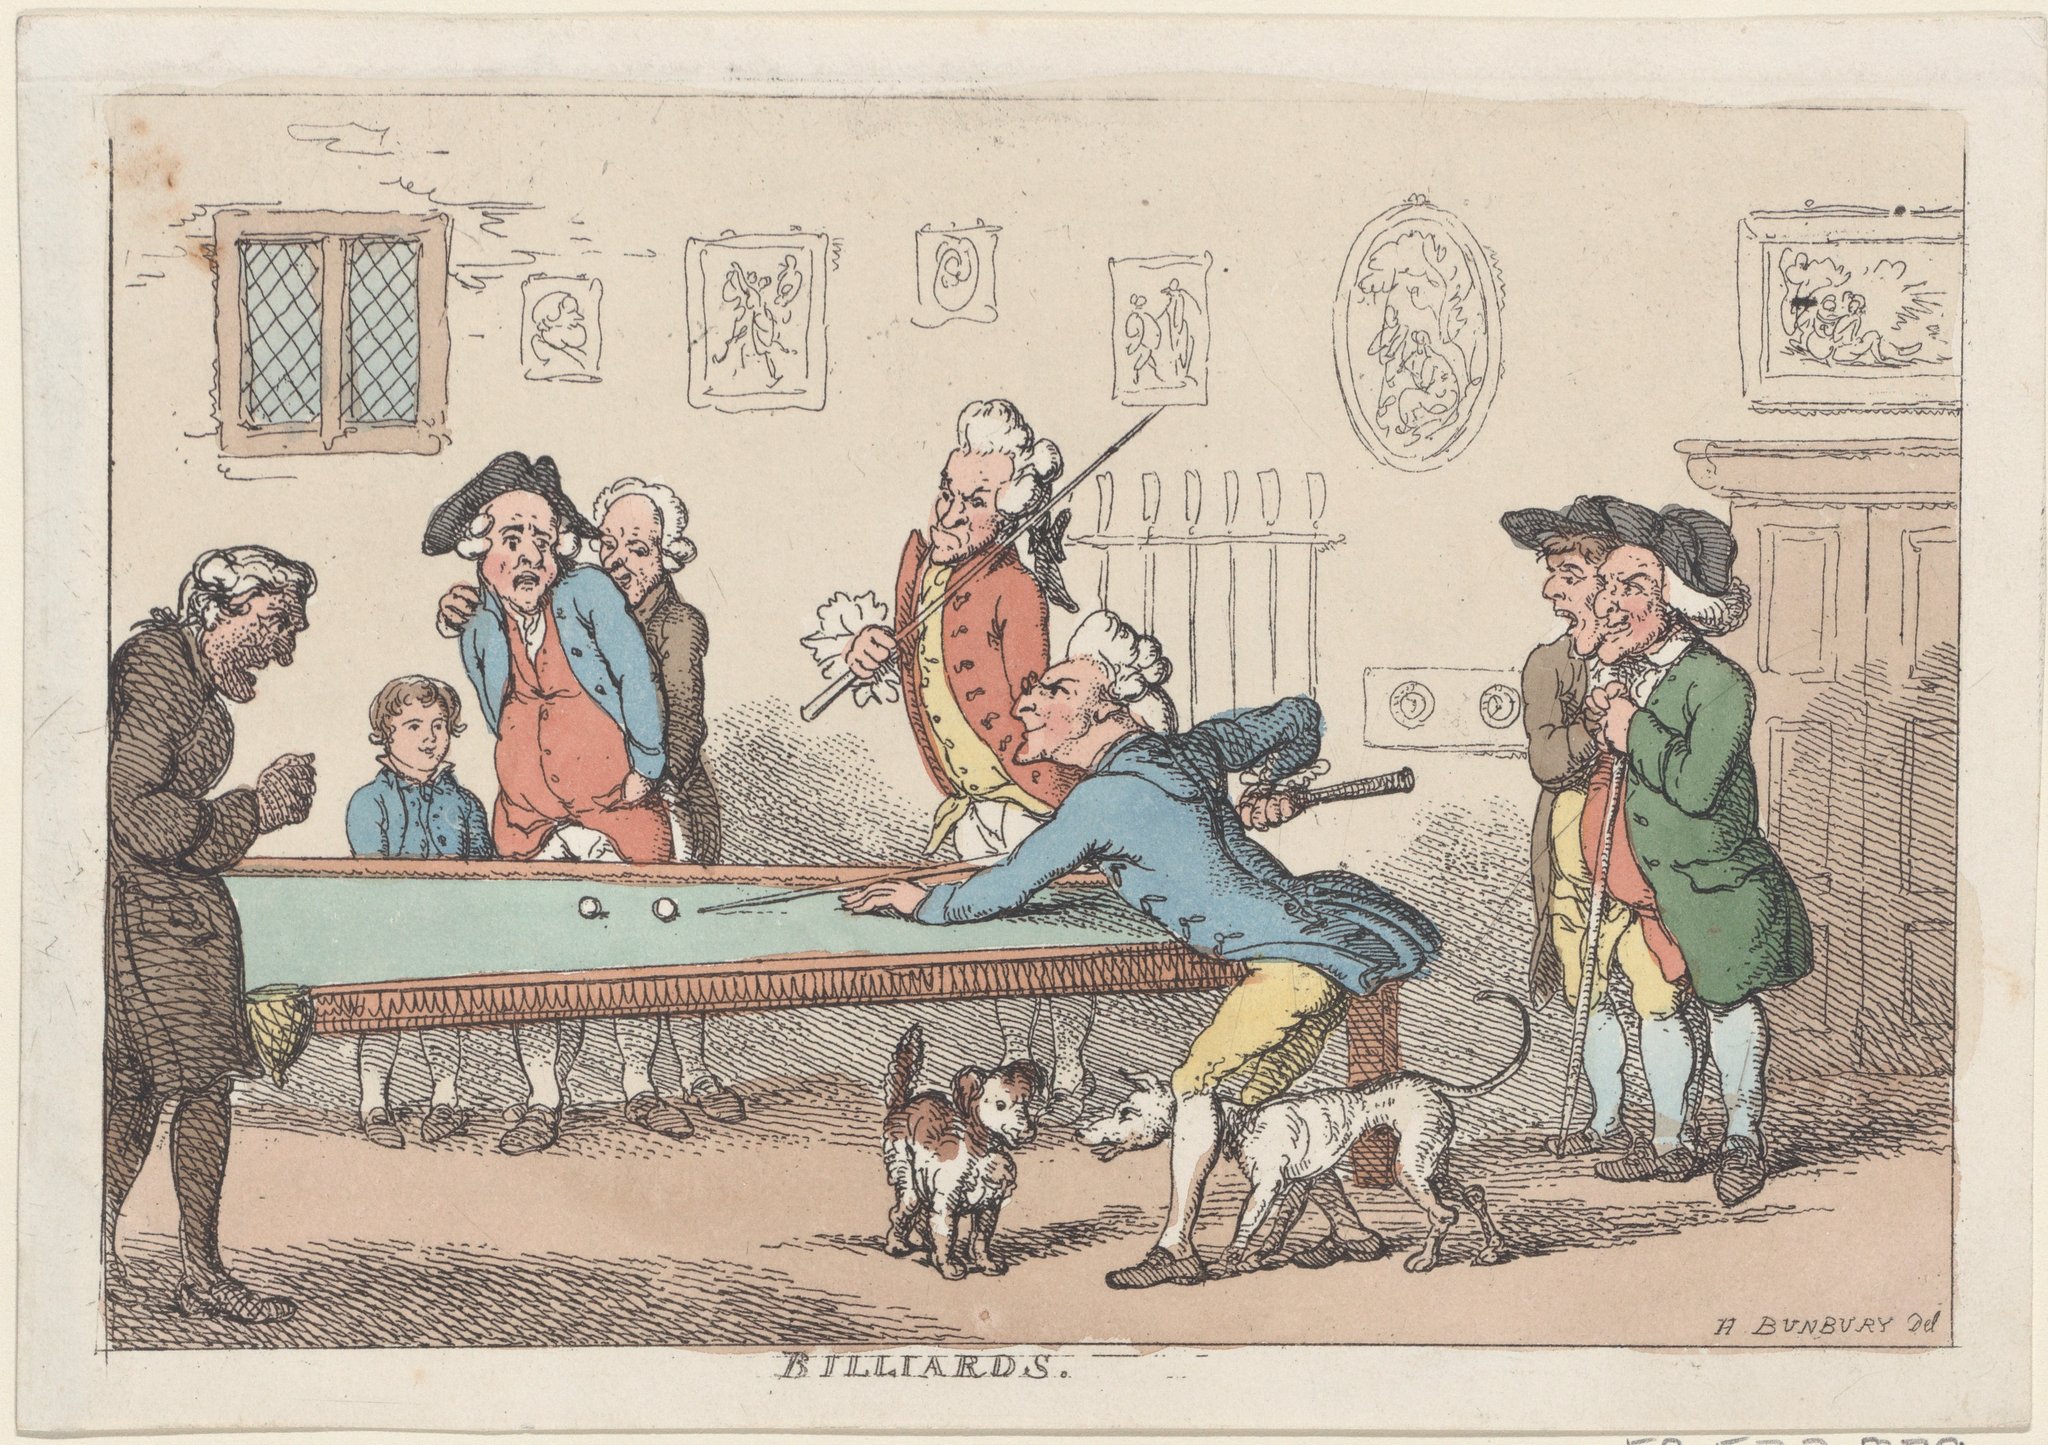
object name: print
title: Billards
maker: anonymous, british, 19th century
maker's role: etcher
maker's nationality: british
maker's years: 1800-1900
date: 1803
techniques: etching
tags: satire,men,billiards,dogs